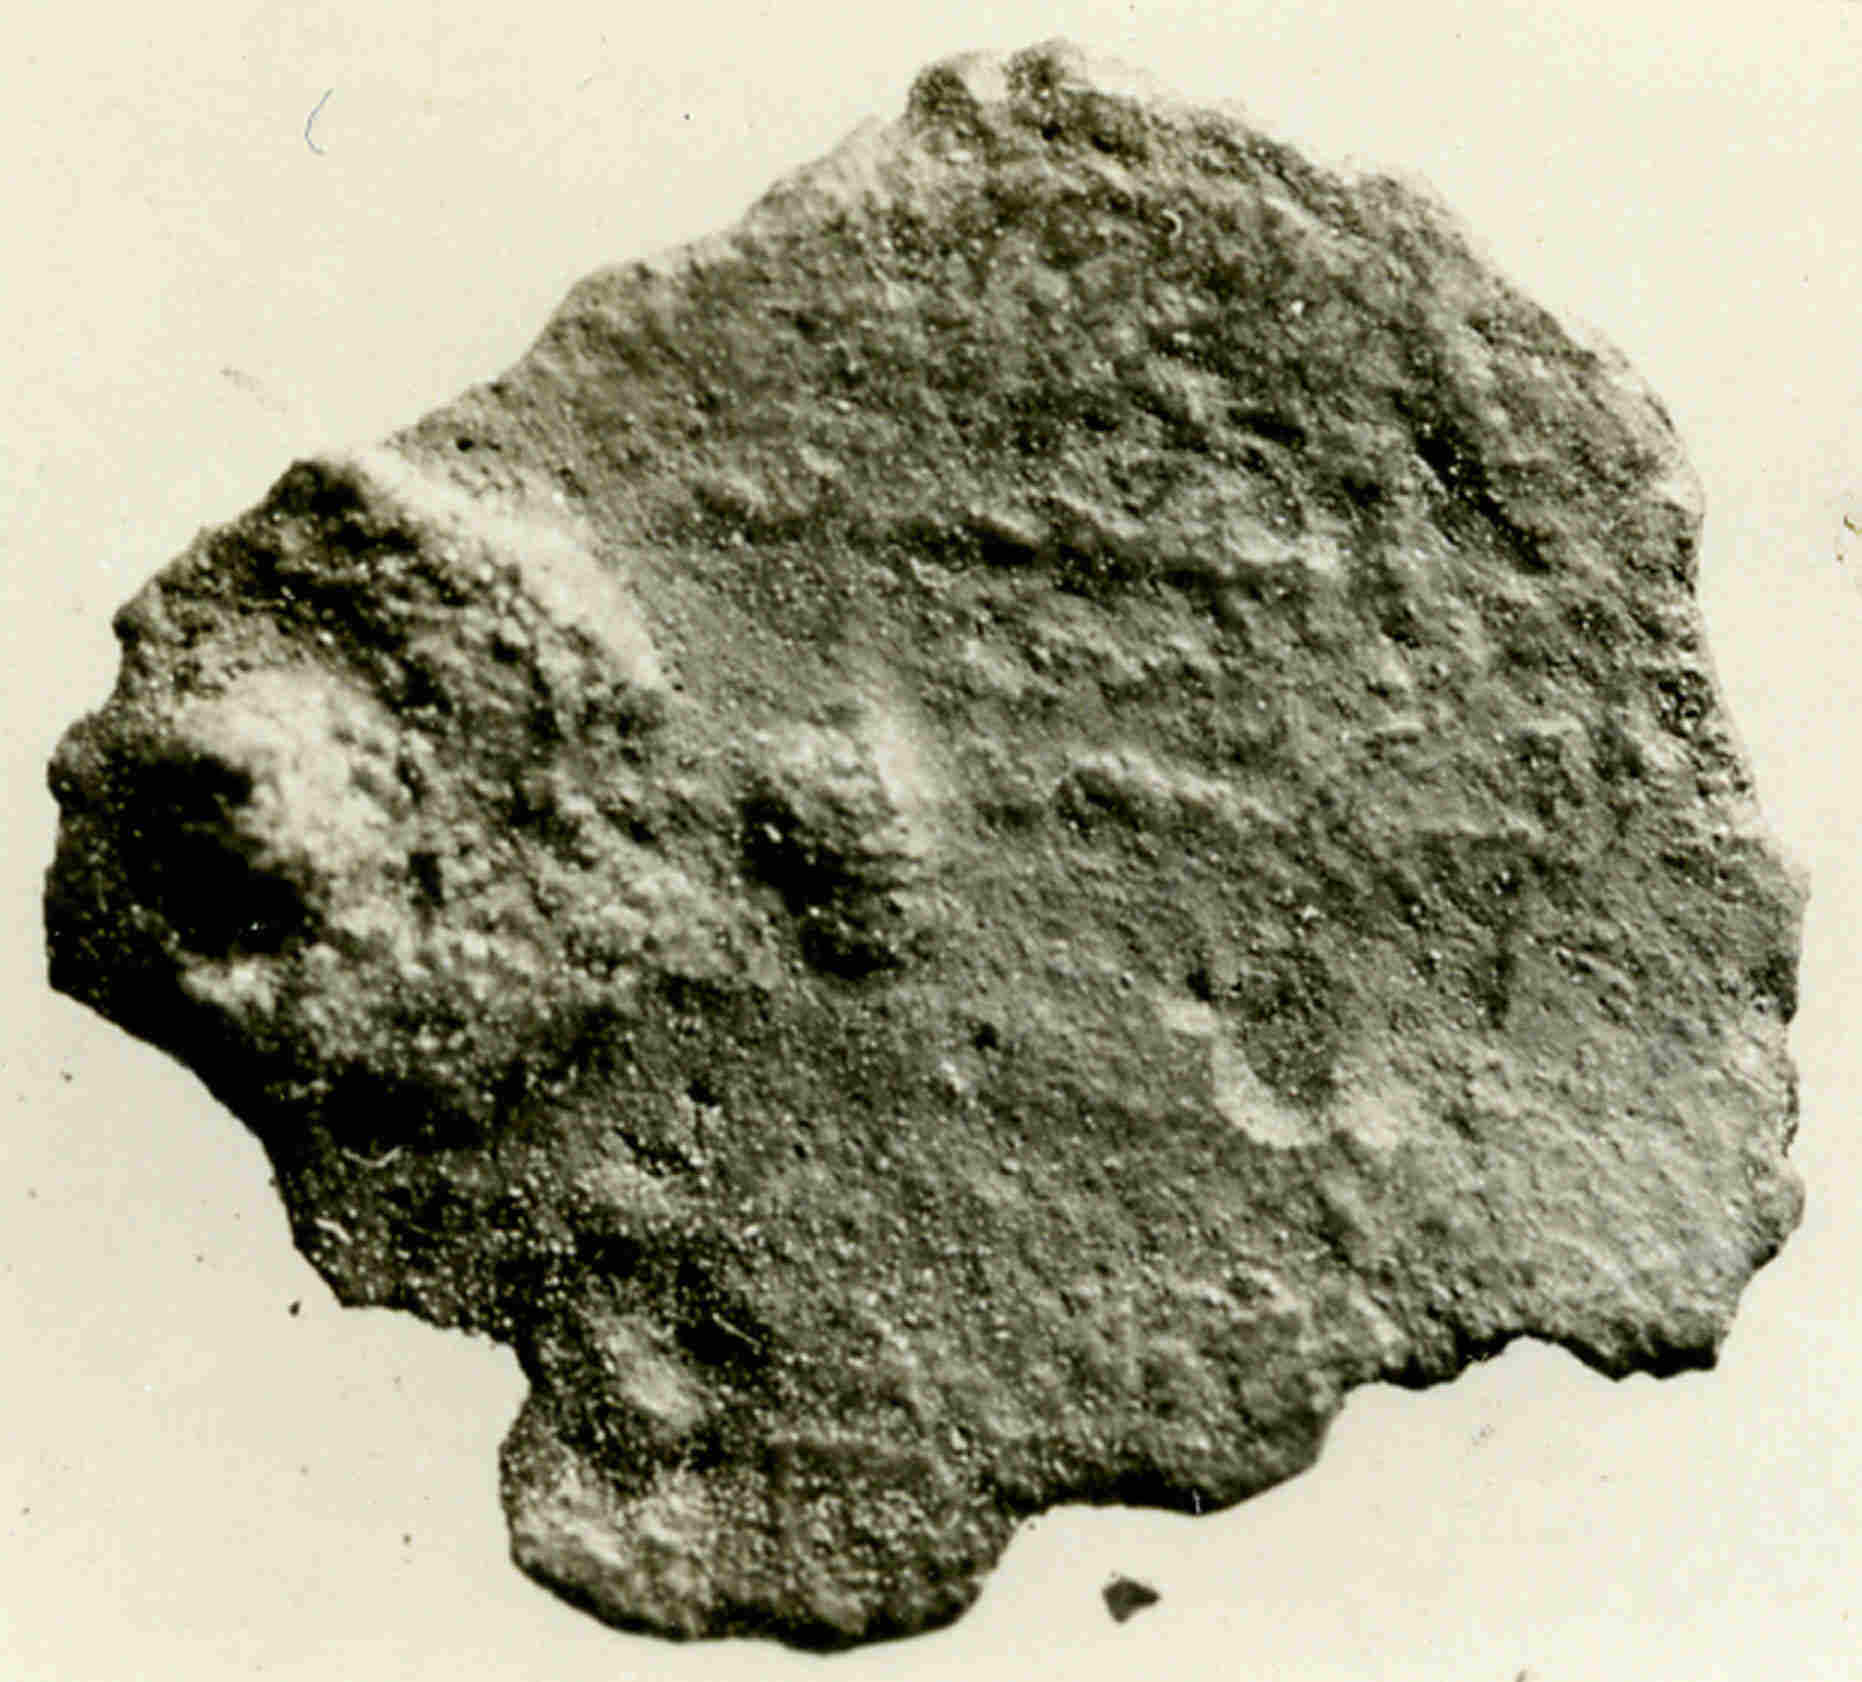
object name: coin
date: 701-900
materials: copper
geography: iran